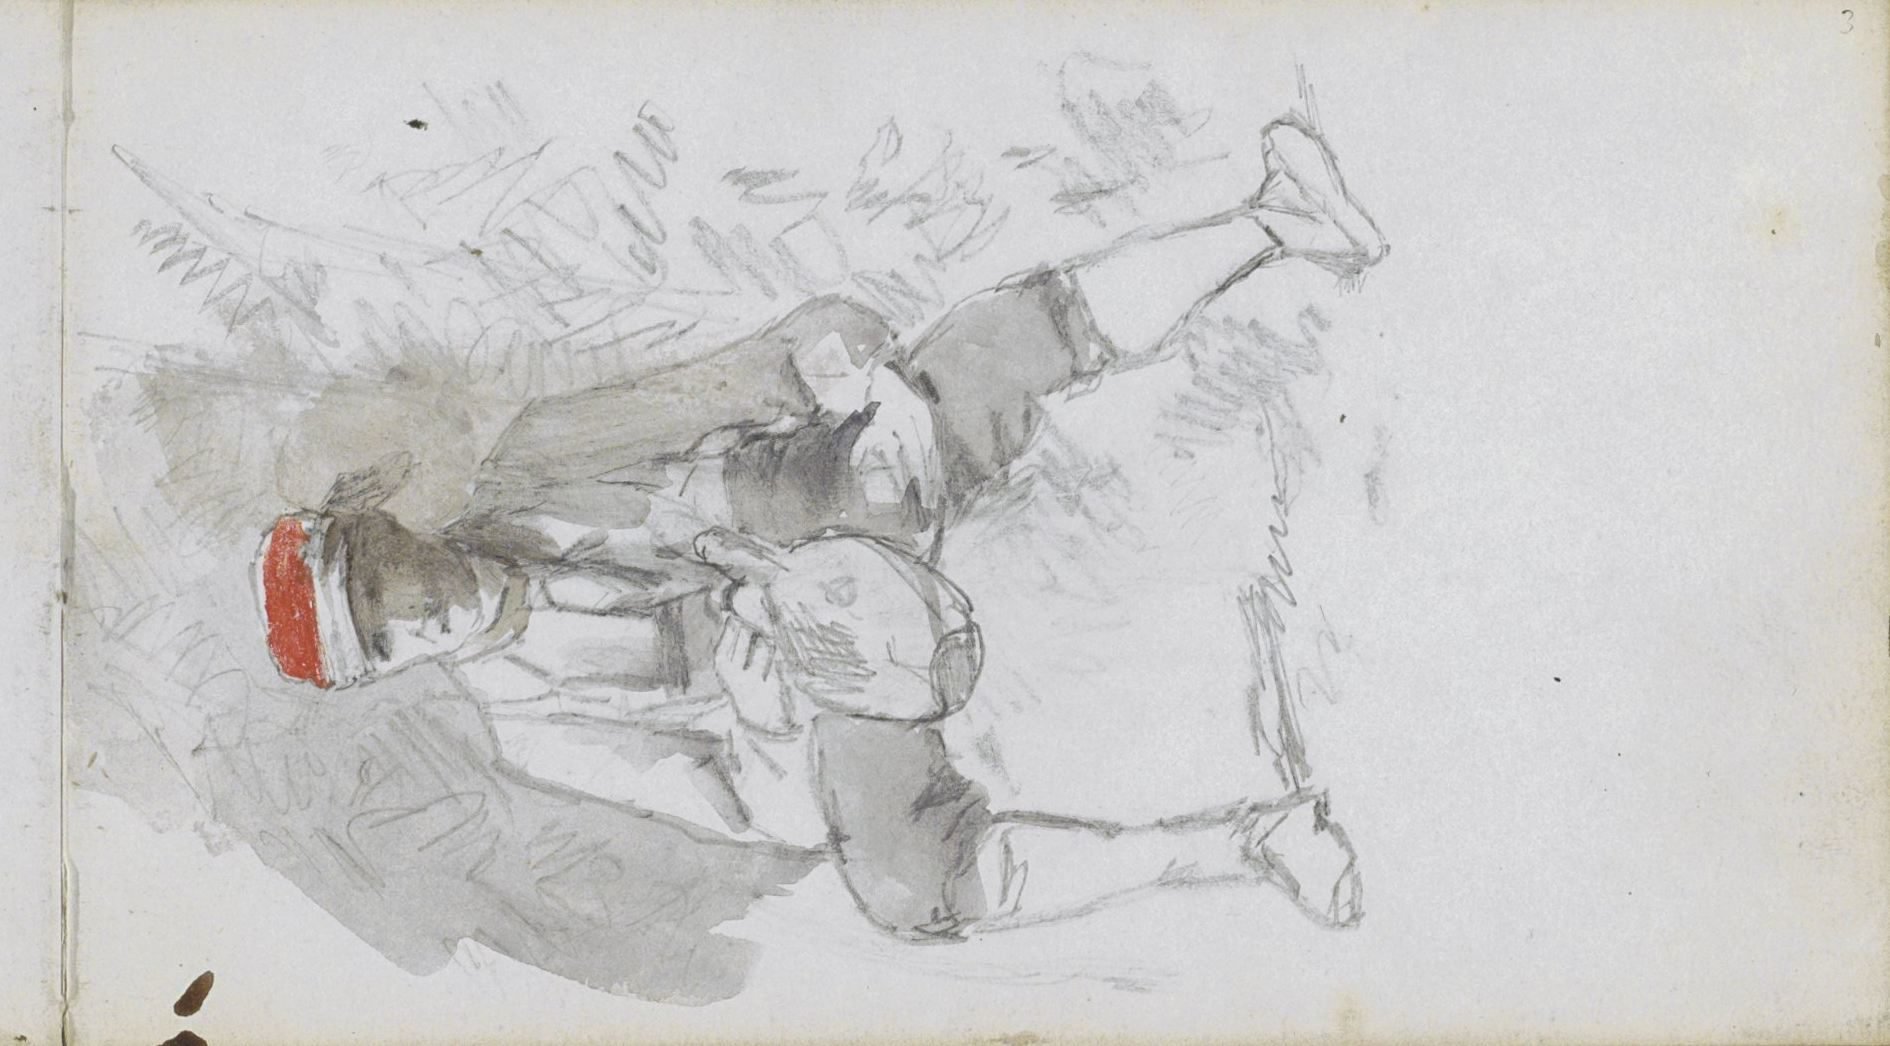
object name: sketchbook leaf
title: Zittende man met een kruik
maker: johan hendrik weissenbruch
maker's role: draughtsman, painter, print maker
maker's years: 1824-1903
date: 1834-1903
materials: paper, pencil, watercolor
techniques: brush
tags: sitting figure (+ male human being (not to be used where -a- is prescribed)), jar, jug (used as drinking-vessel)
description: De man zit tussen het gebladerte. Blad 3 recto uit een schetsboek met 39 bladen.